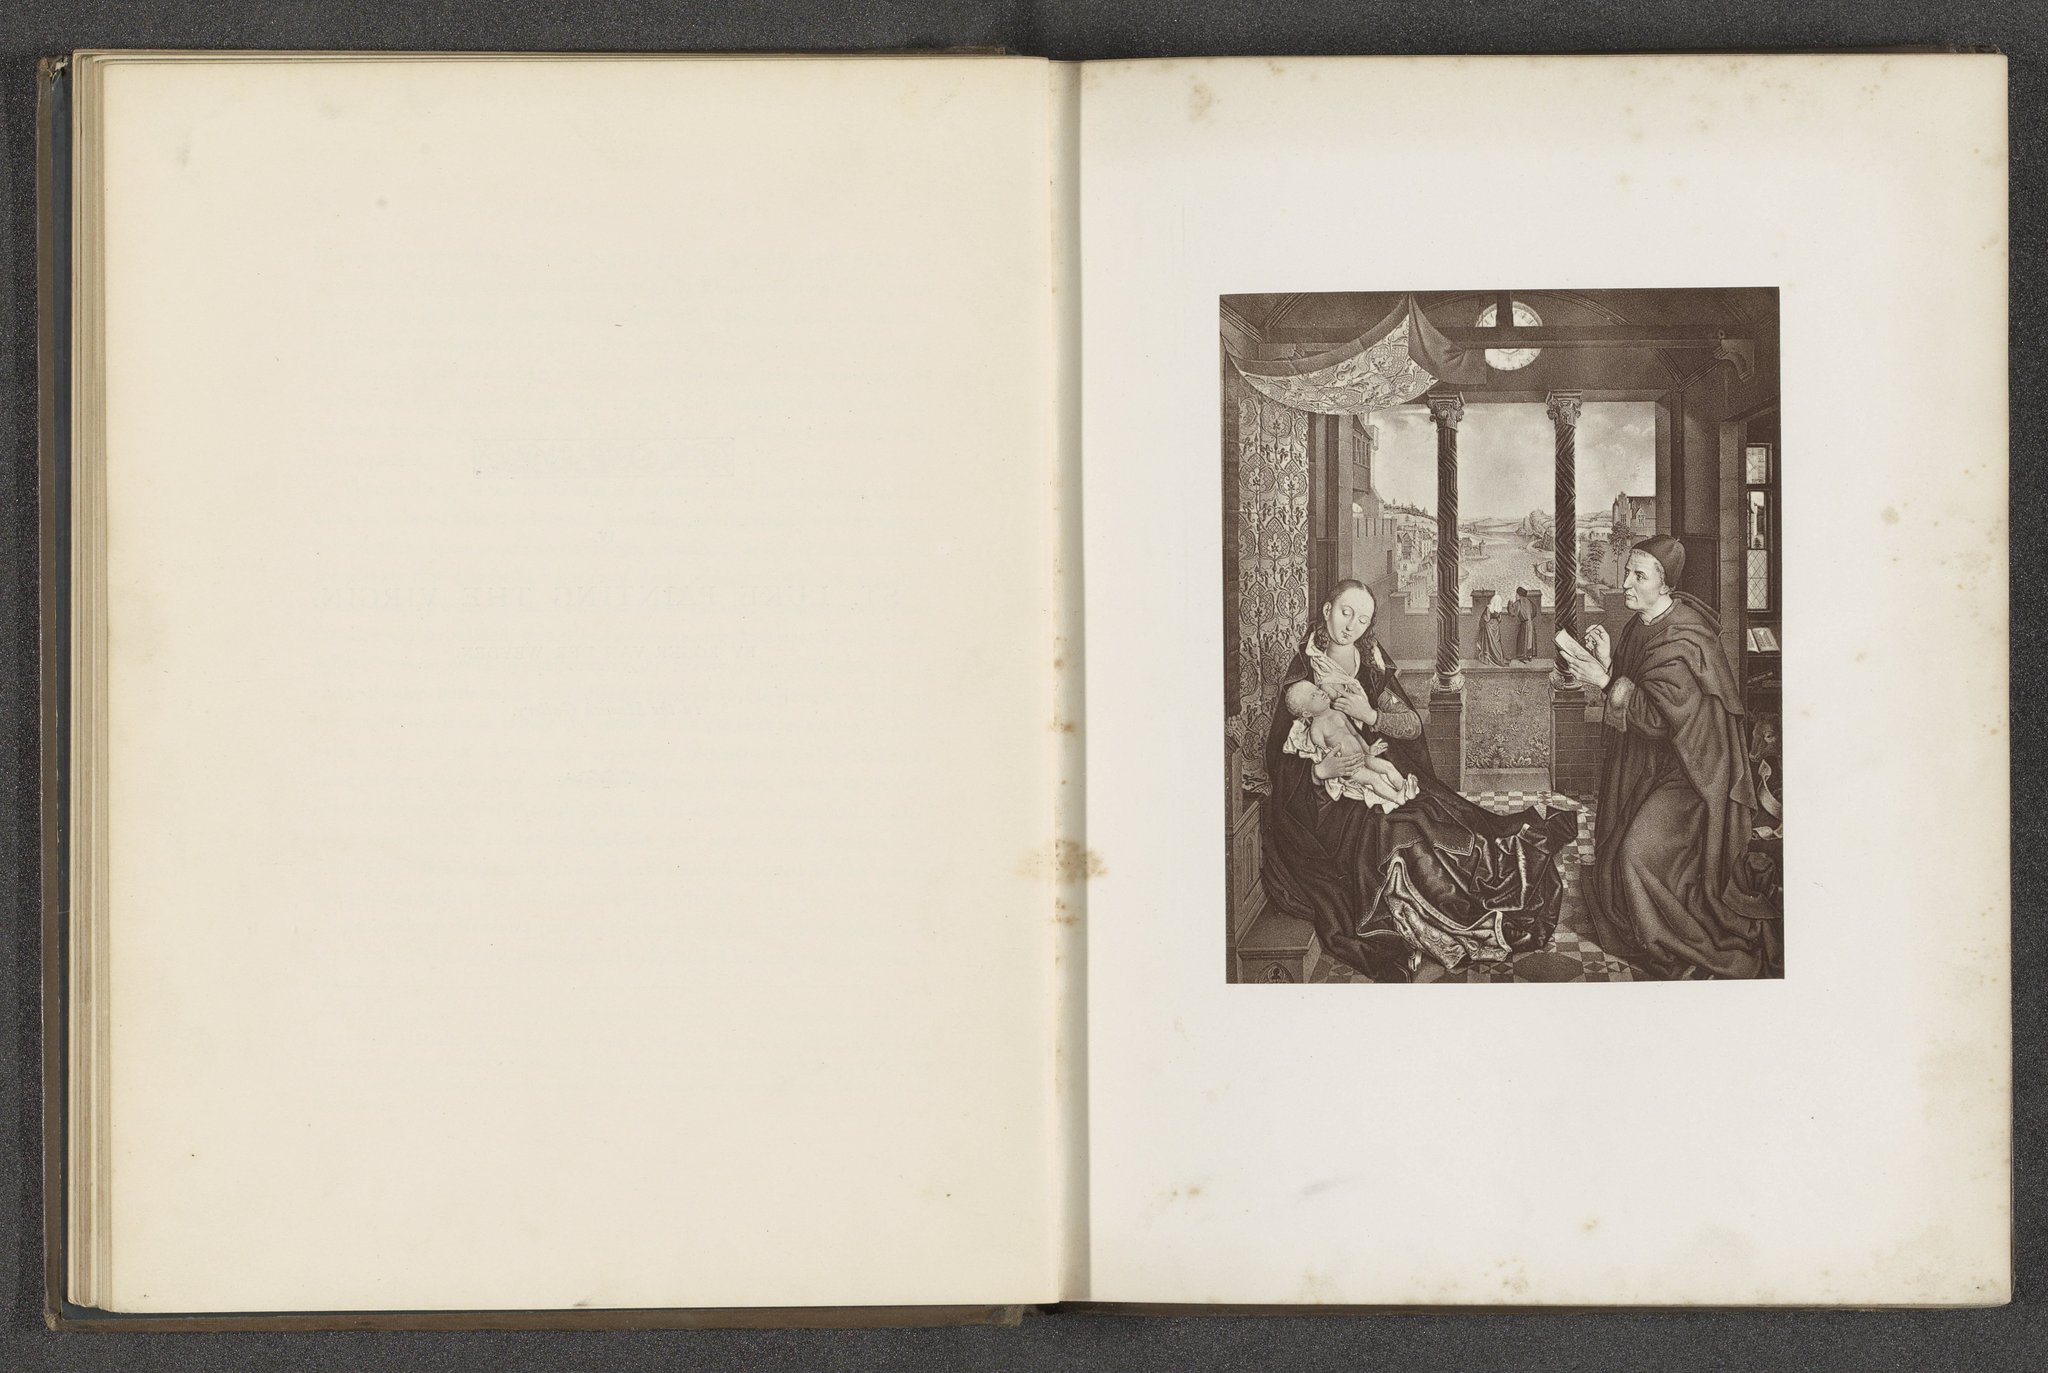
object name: reproduction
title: Fotoreproductie van een prent naar een schilderij, voorstellende Lucas tekent de Madonna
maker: Anonymous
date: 1859-1869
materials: paper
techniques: woodburytype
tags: st.luke painting or drawing the madonna (i.e. mary and the christ-child), sometimes joseph present